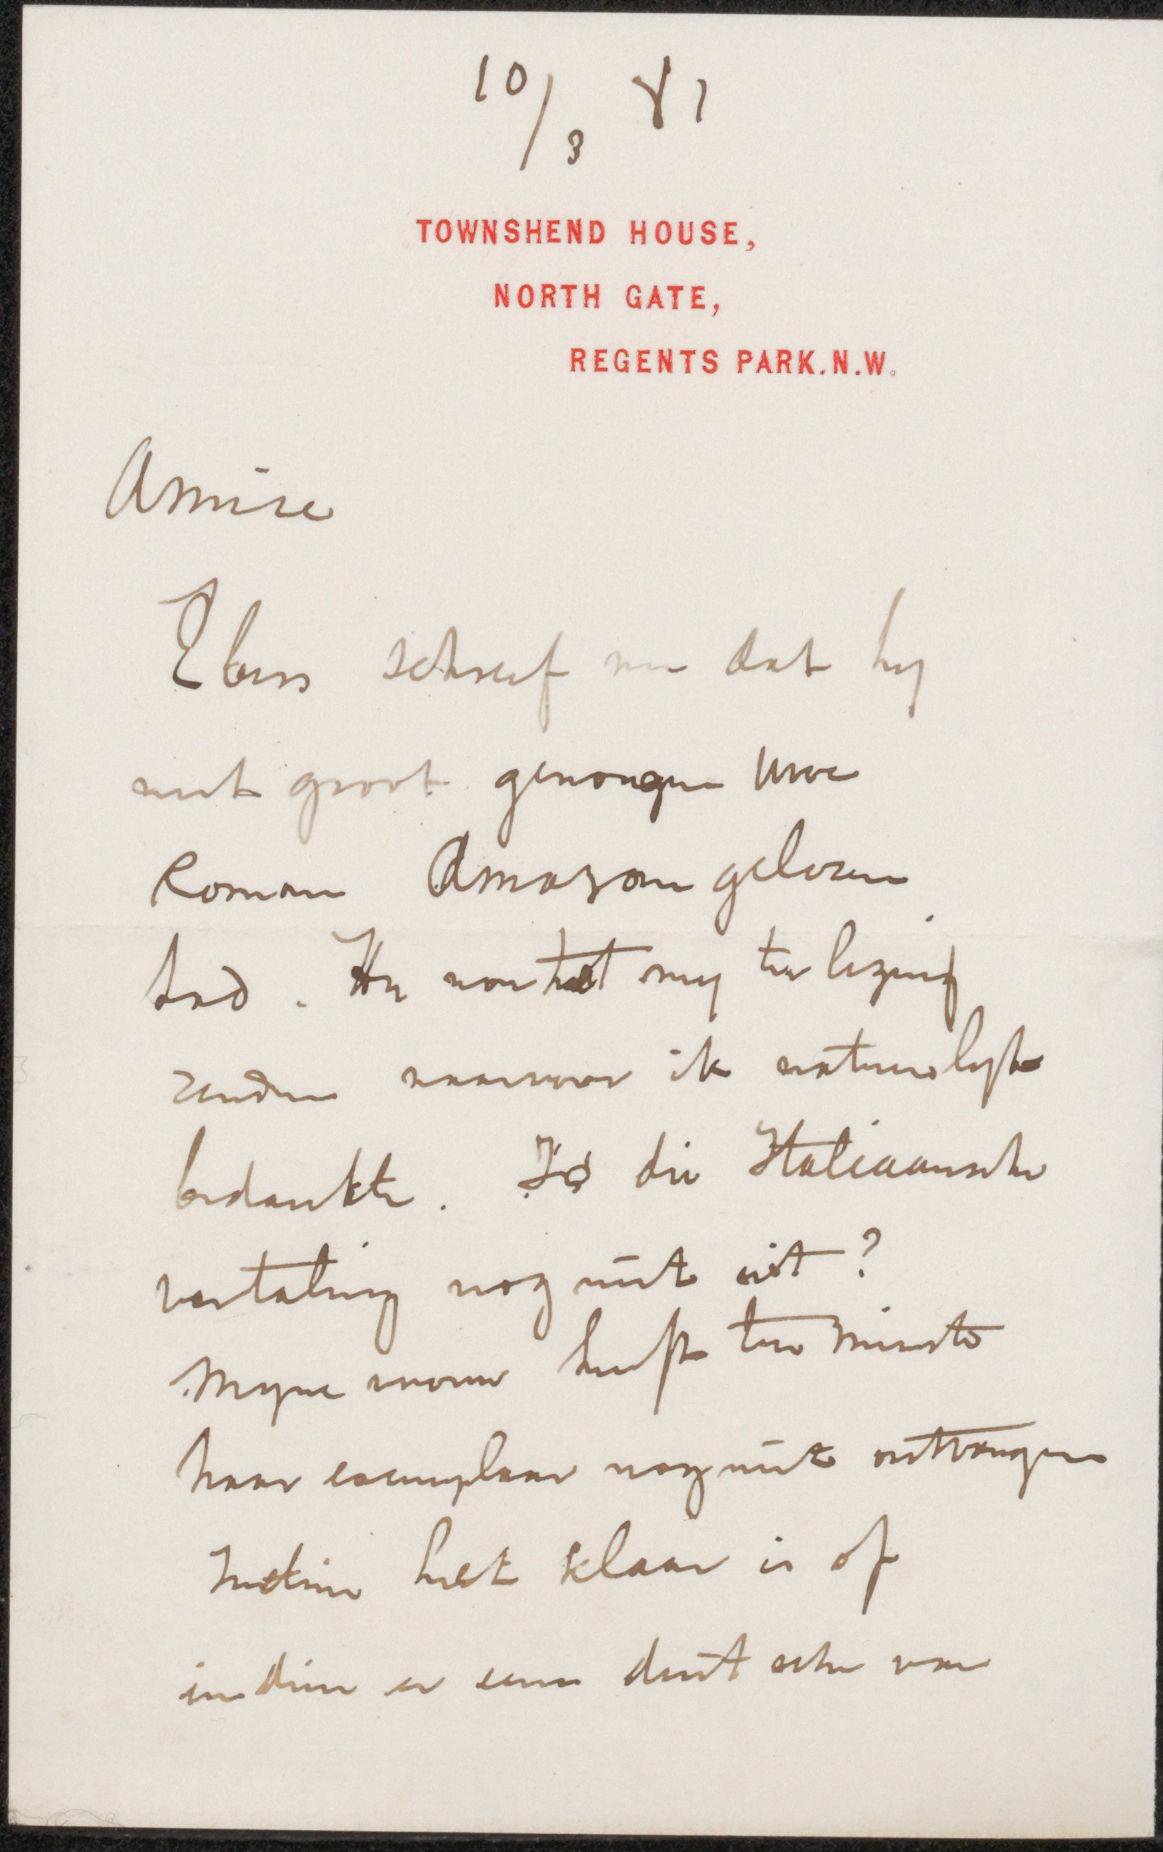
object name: letter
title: Brief aan Carel Vosmaer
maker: lourens alma tadema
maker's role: draughtsman, print maker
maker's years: 1836-1912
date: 1881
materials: ink, paper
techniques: pen, printing, writing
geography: london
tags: berlin, the hague, carel vosmaer, literature ~ arts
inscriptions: watermark